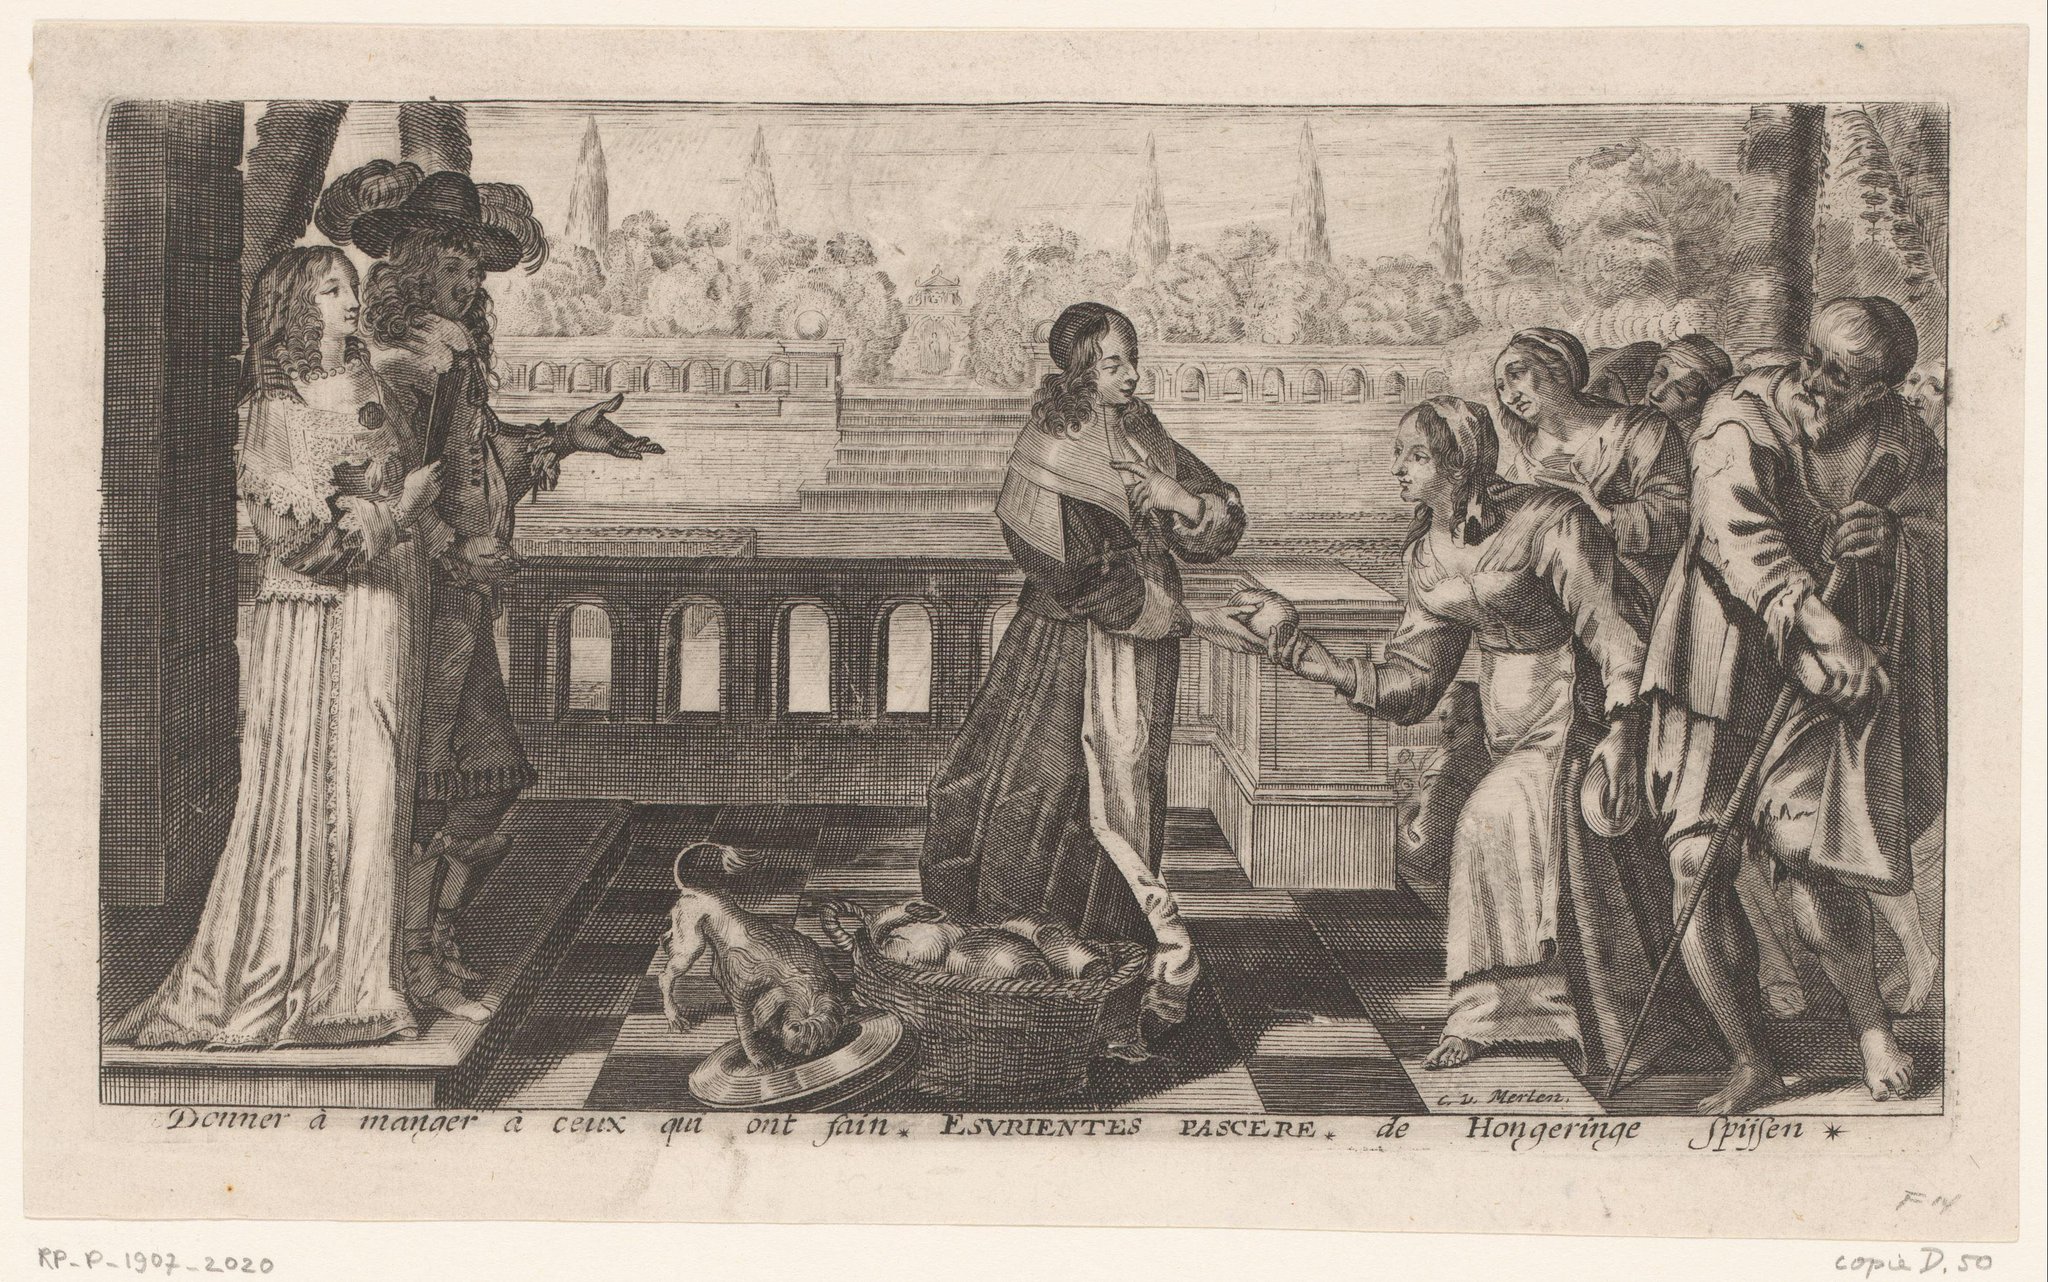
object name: print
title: Les sept oeuvres de miséricorde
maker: cornelis van merlen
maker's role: print maker, publisher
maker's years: 1654-1723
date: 1664-1723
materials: paper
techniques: engraving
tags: feeding the hungry, 'esuriens cibatur' ~ one of the (seven) acts of mercy, the (seven) acts of mercy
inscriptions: collector's mark: Lugt 2228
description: Betreft een gedeeltelijke, spiegelbeeldige kopie naar een prent door Abraham Bosse uit een serie van zeven prenten met als onderwerp de zeven werken van barmhartigheid, uitgegeven tussen 1640 en 1642 door Jean Leblond (I) in Parijs. Zie Lothe 2008, nrs. 22-28.